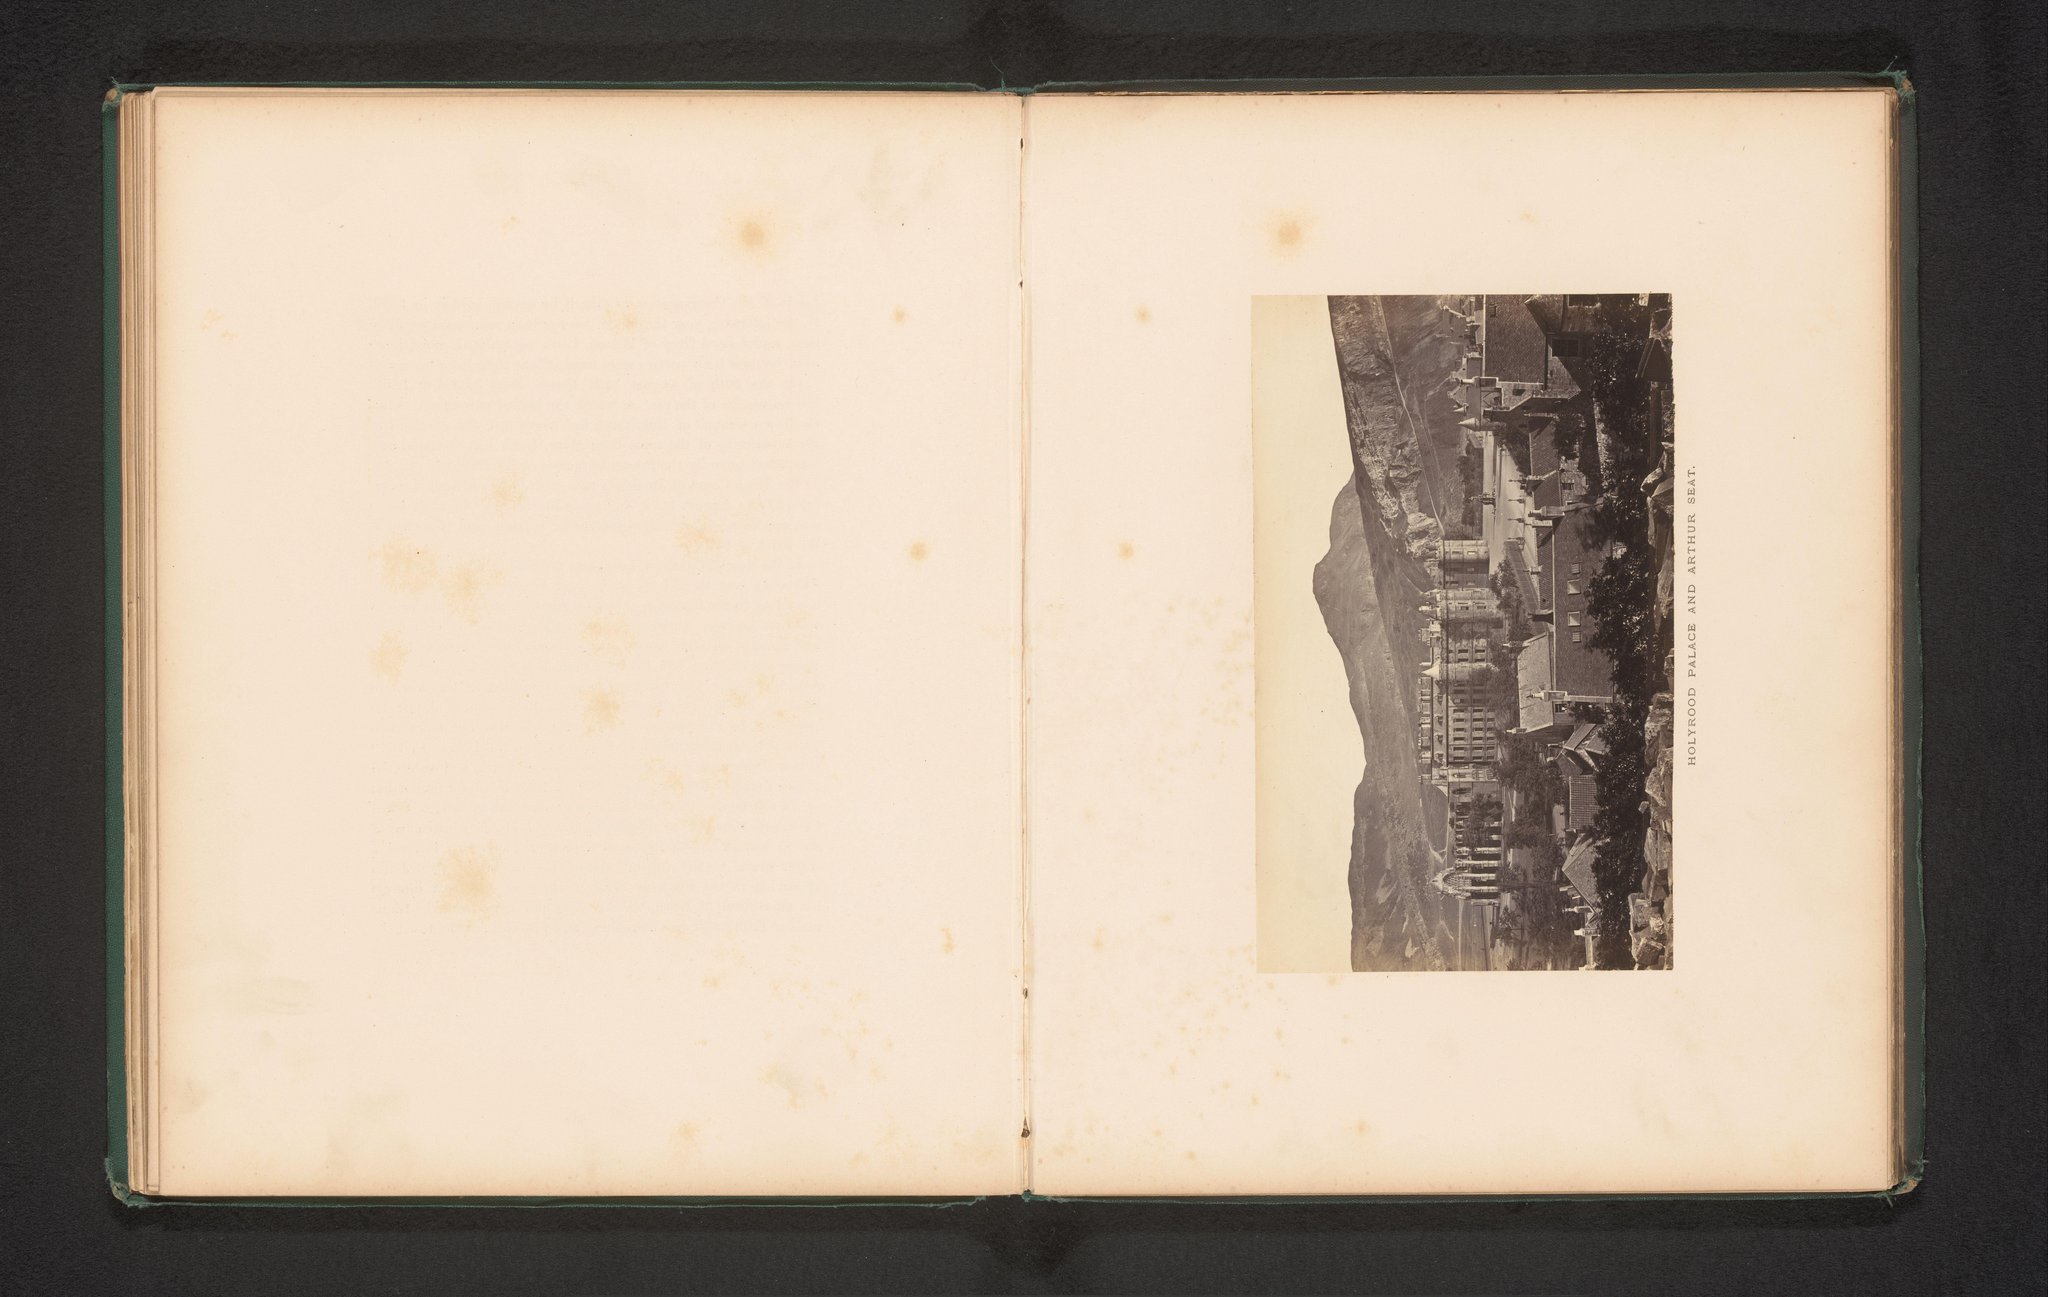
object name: page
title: Holyrood Palace and Arthur Seat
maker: archibald burns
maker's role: fotograaf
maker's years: 1831-1880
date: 1862-1867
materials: photographic support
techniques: albumen print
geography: edinburgh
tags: city-view in general; 'veduta', (high) hill, palace